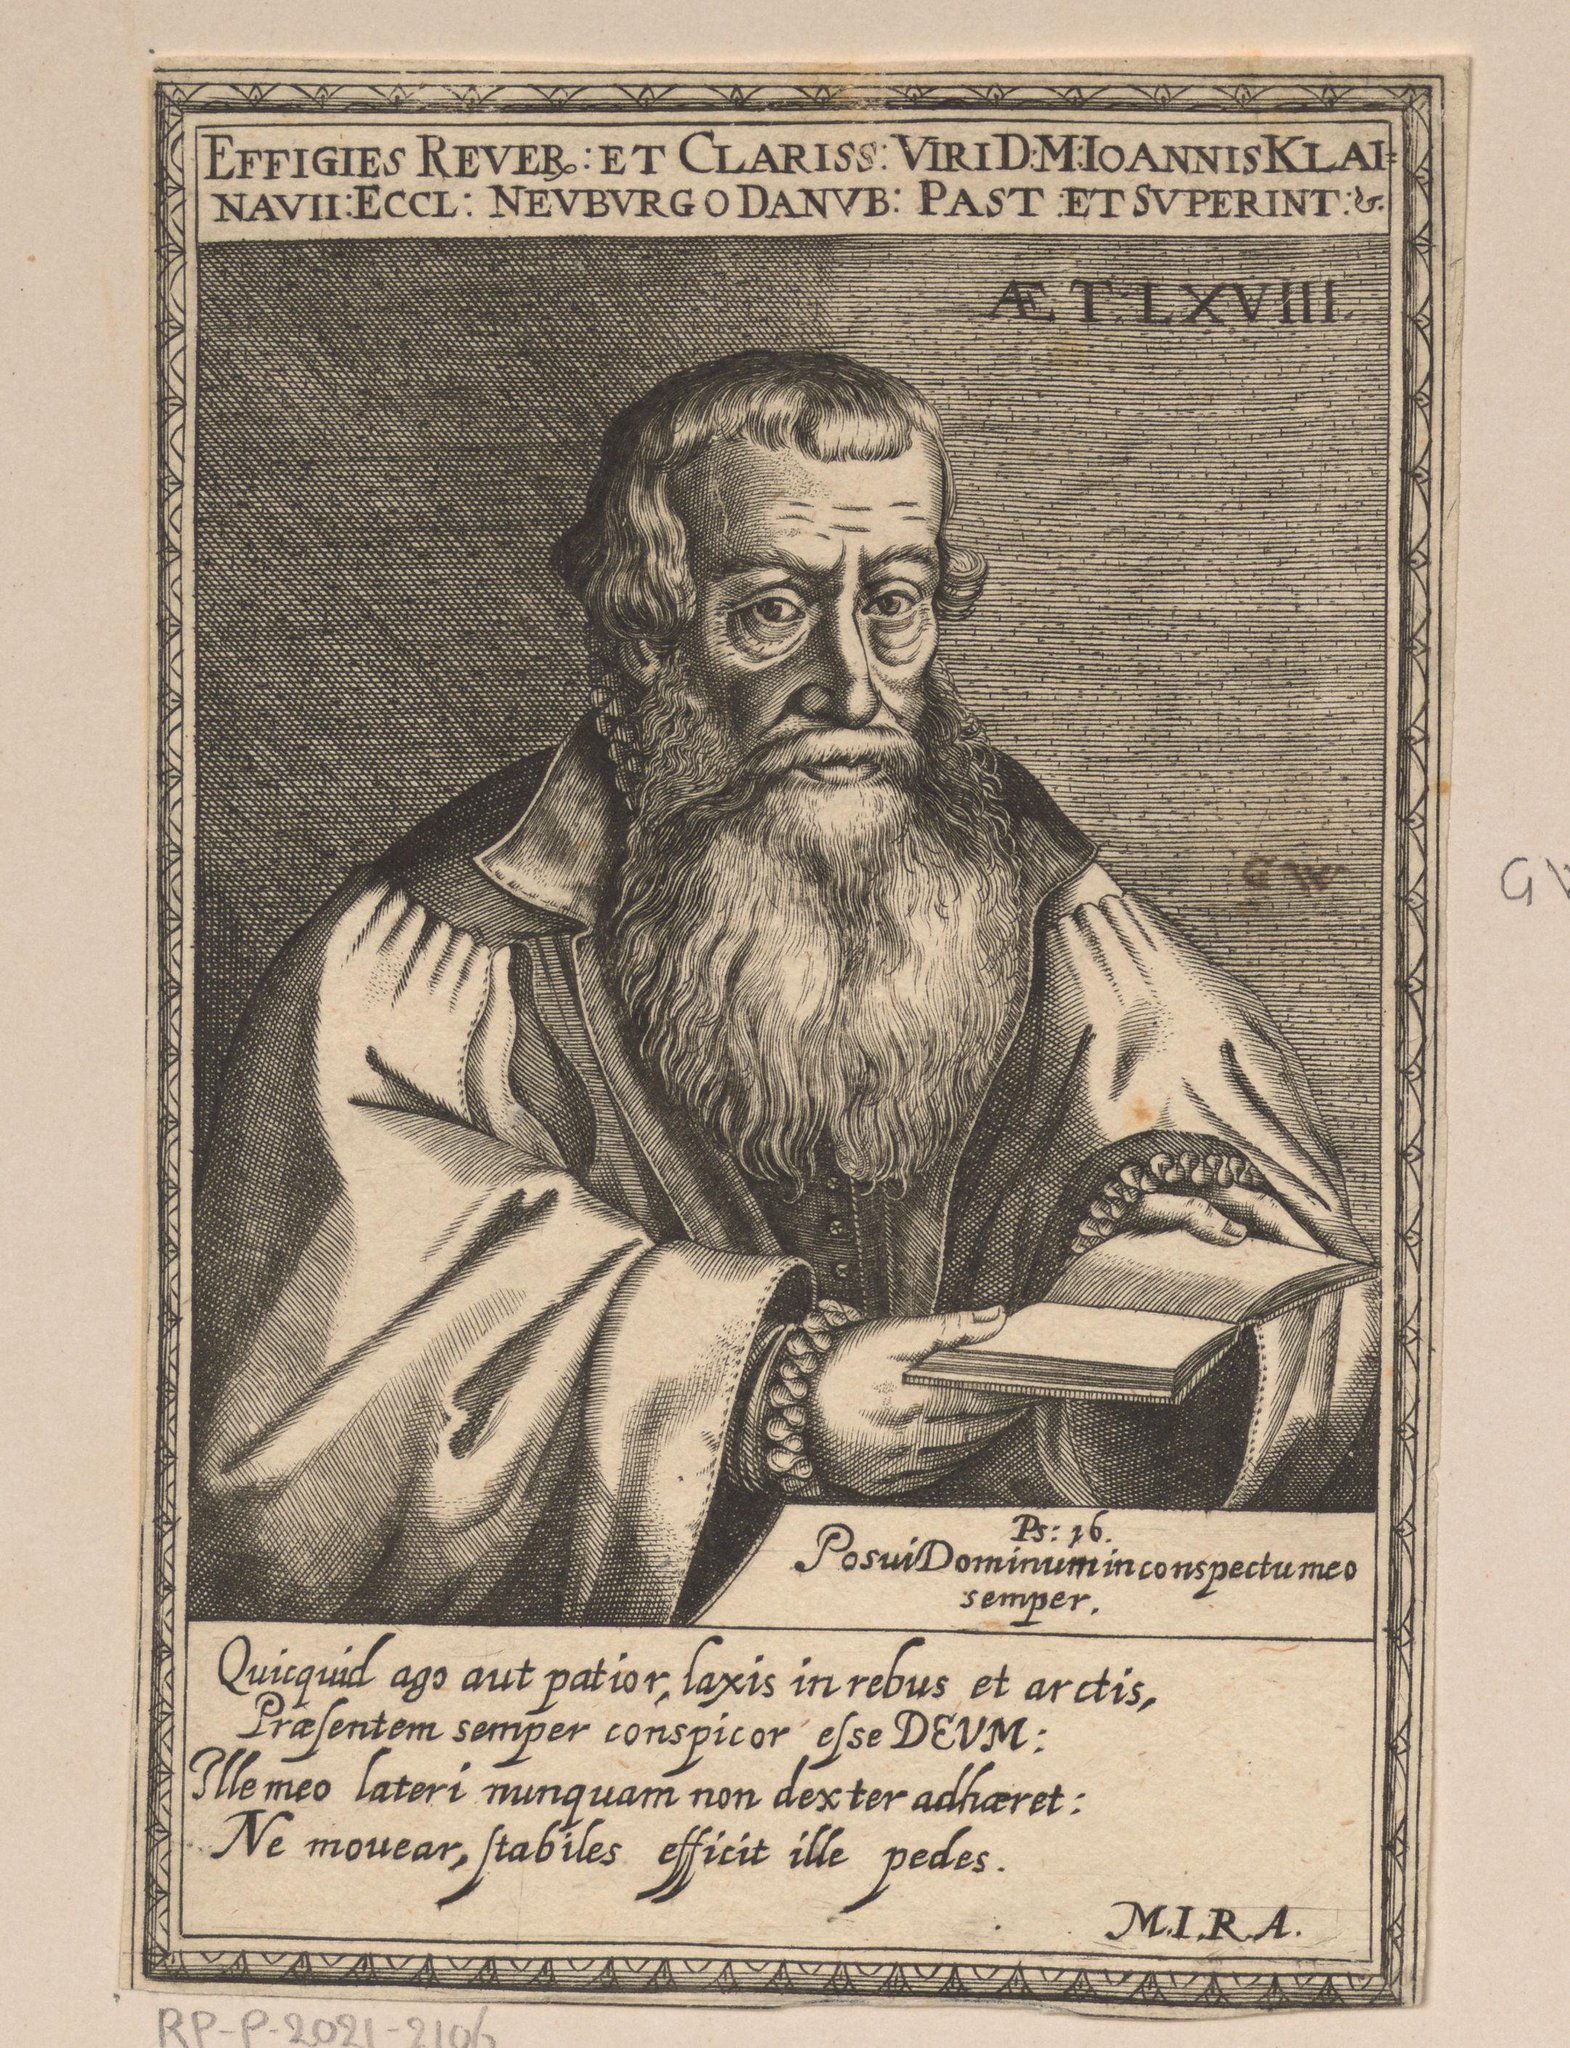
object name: print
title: Portret van Johann Klainau op 68-jarige leeftijd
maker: Anonymous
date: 1570-1664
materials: paper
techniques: engraving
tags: historical persons, book